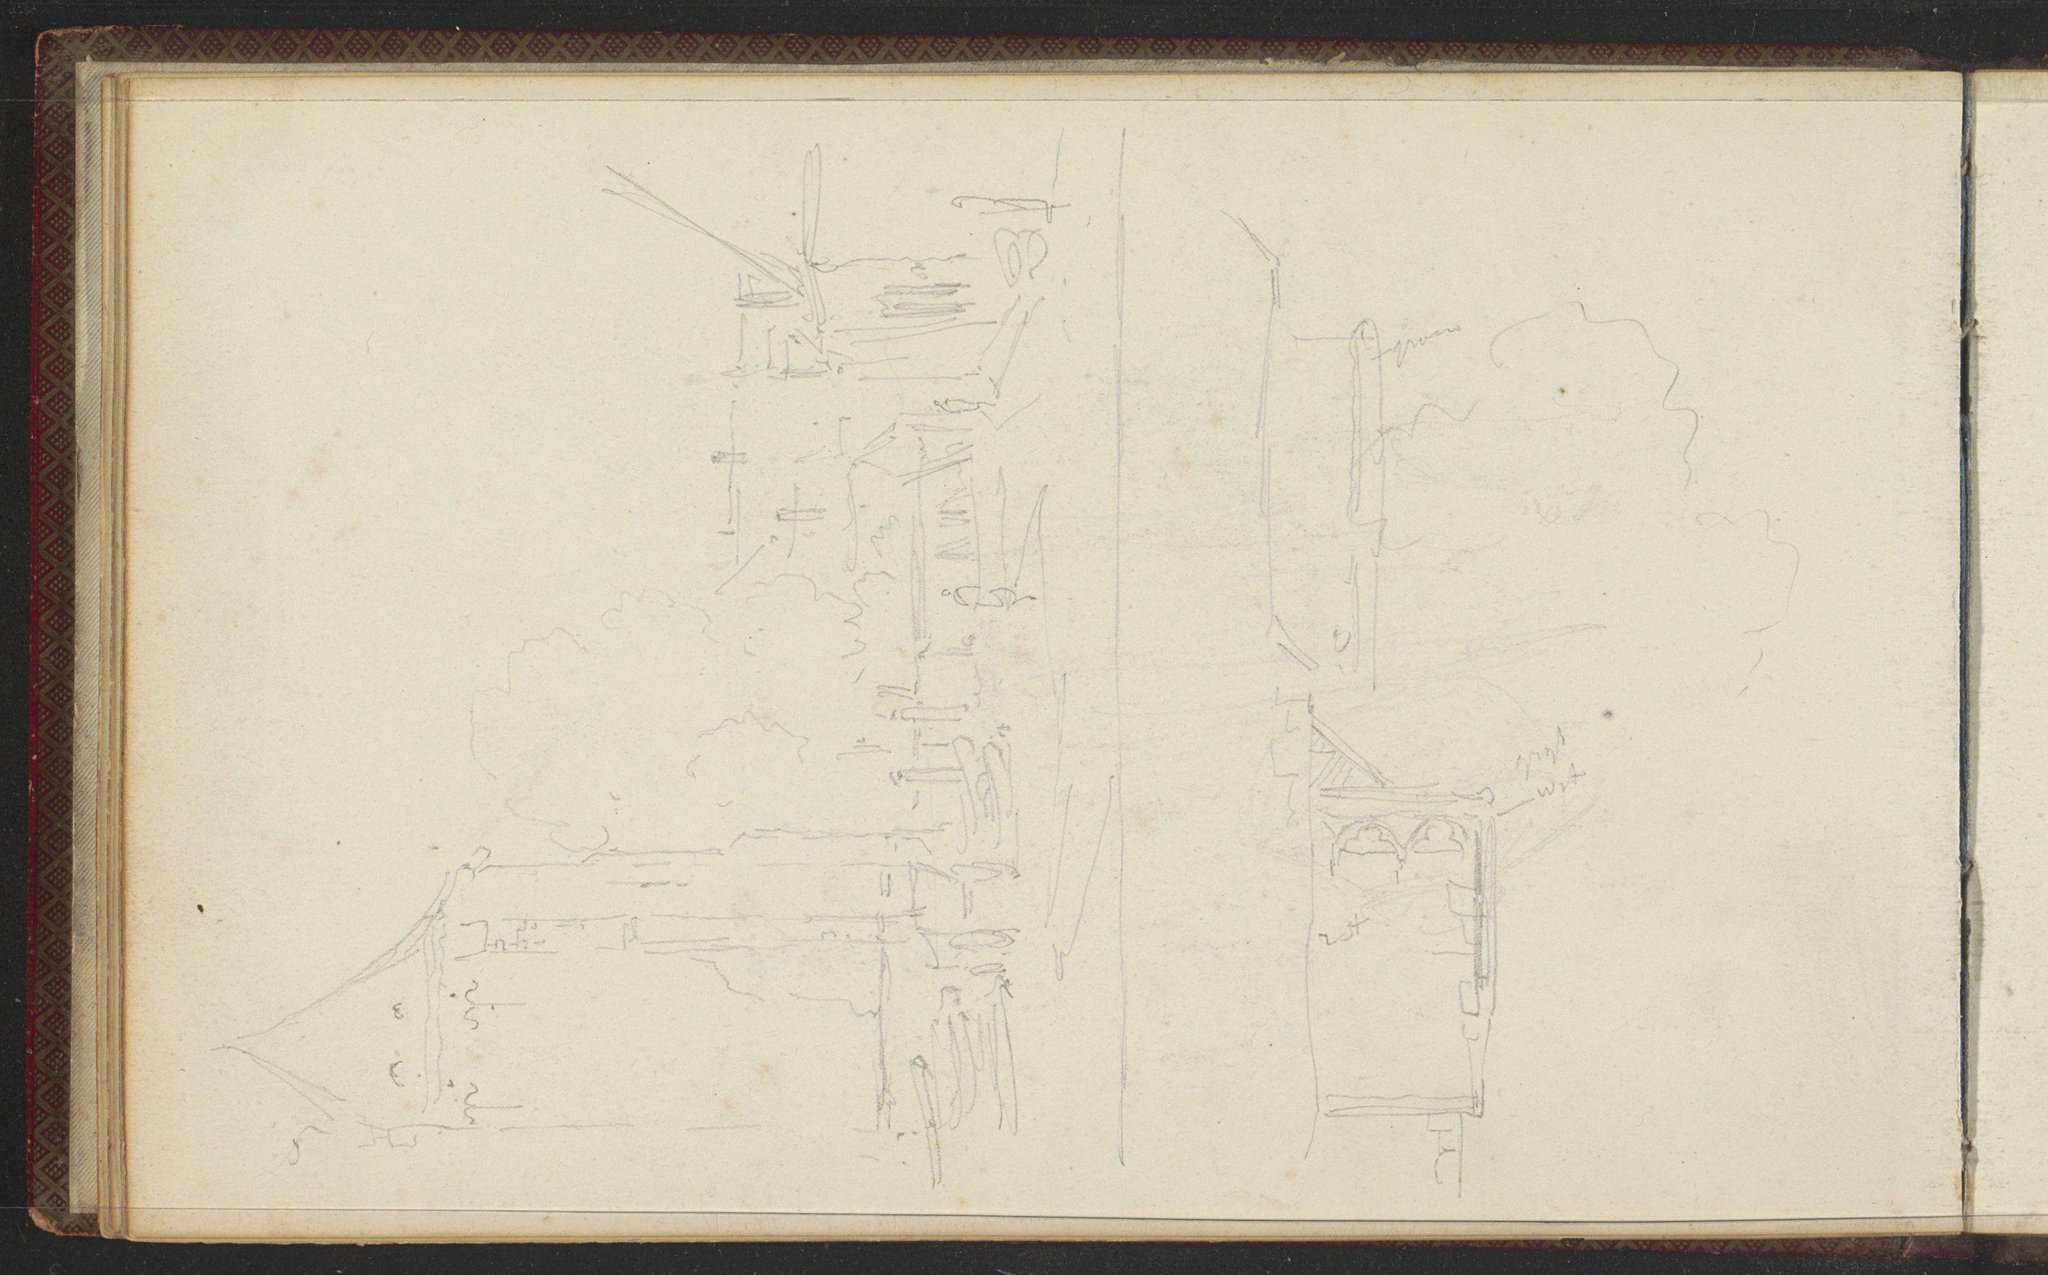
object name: sketchbook leaf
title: Stadsgezicht en een architectonisch detail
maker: adrianus eversen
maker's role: draughtsman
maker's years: 1818-1897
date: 1828-1897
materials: paper, pencil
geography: netherlands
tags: architectural detail, street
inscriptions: kleurnotitie, handgeschreven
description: Boven een gezicht op een straat. Vooraan staat een figuur. Onder een studie van een architectonisch detail. Blad 12 verso uit een schetsboek met 52 bladen vervaardigd in de omgeving van Kampen, Hattem, Hoorn en Zwolle.